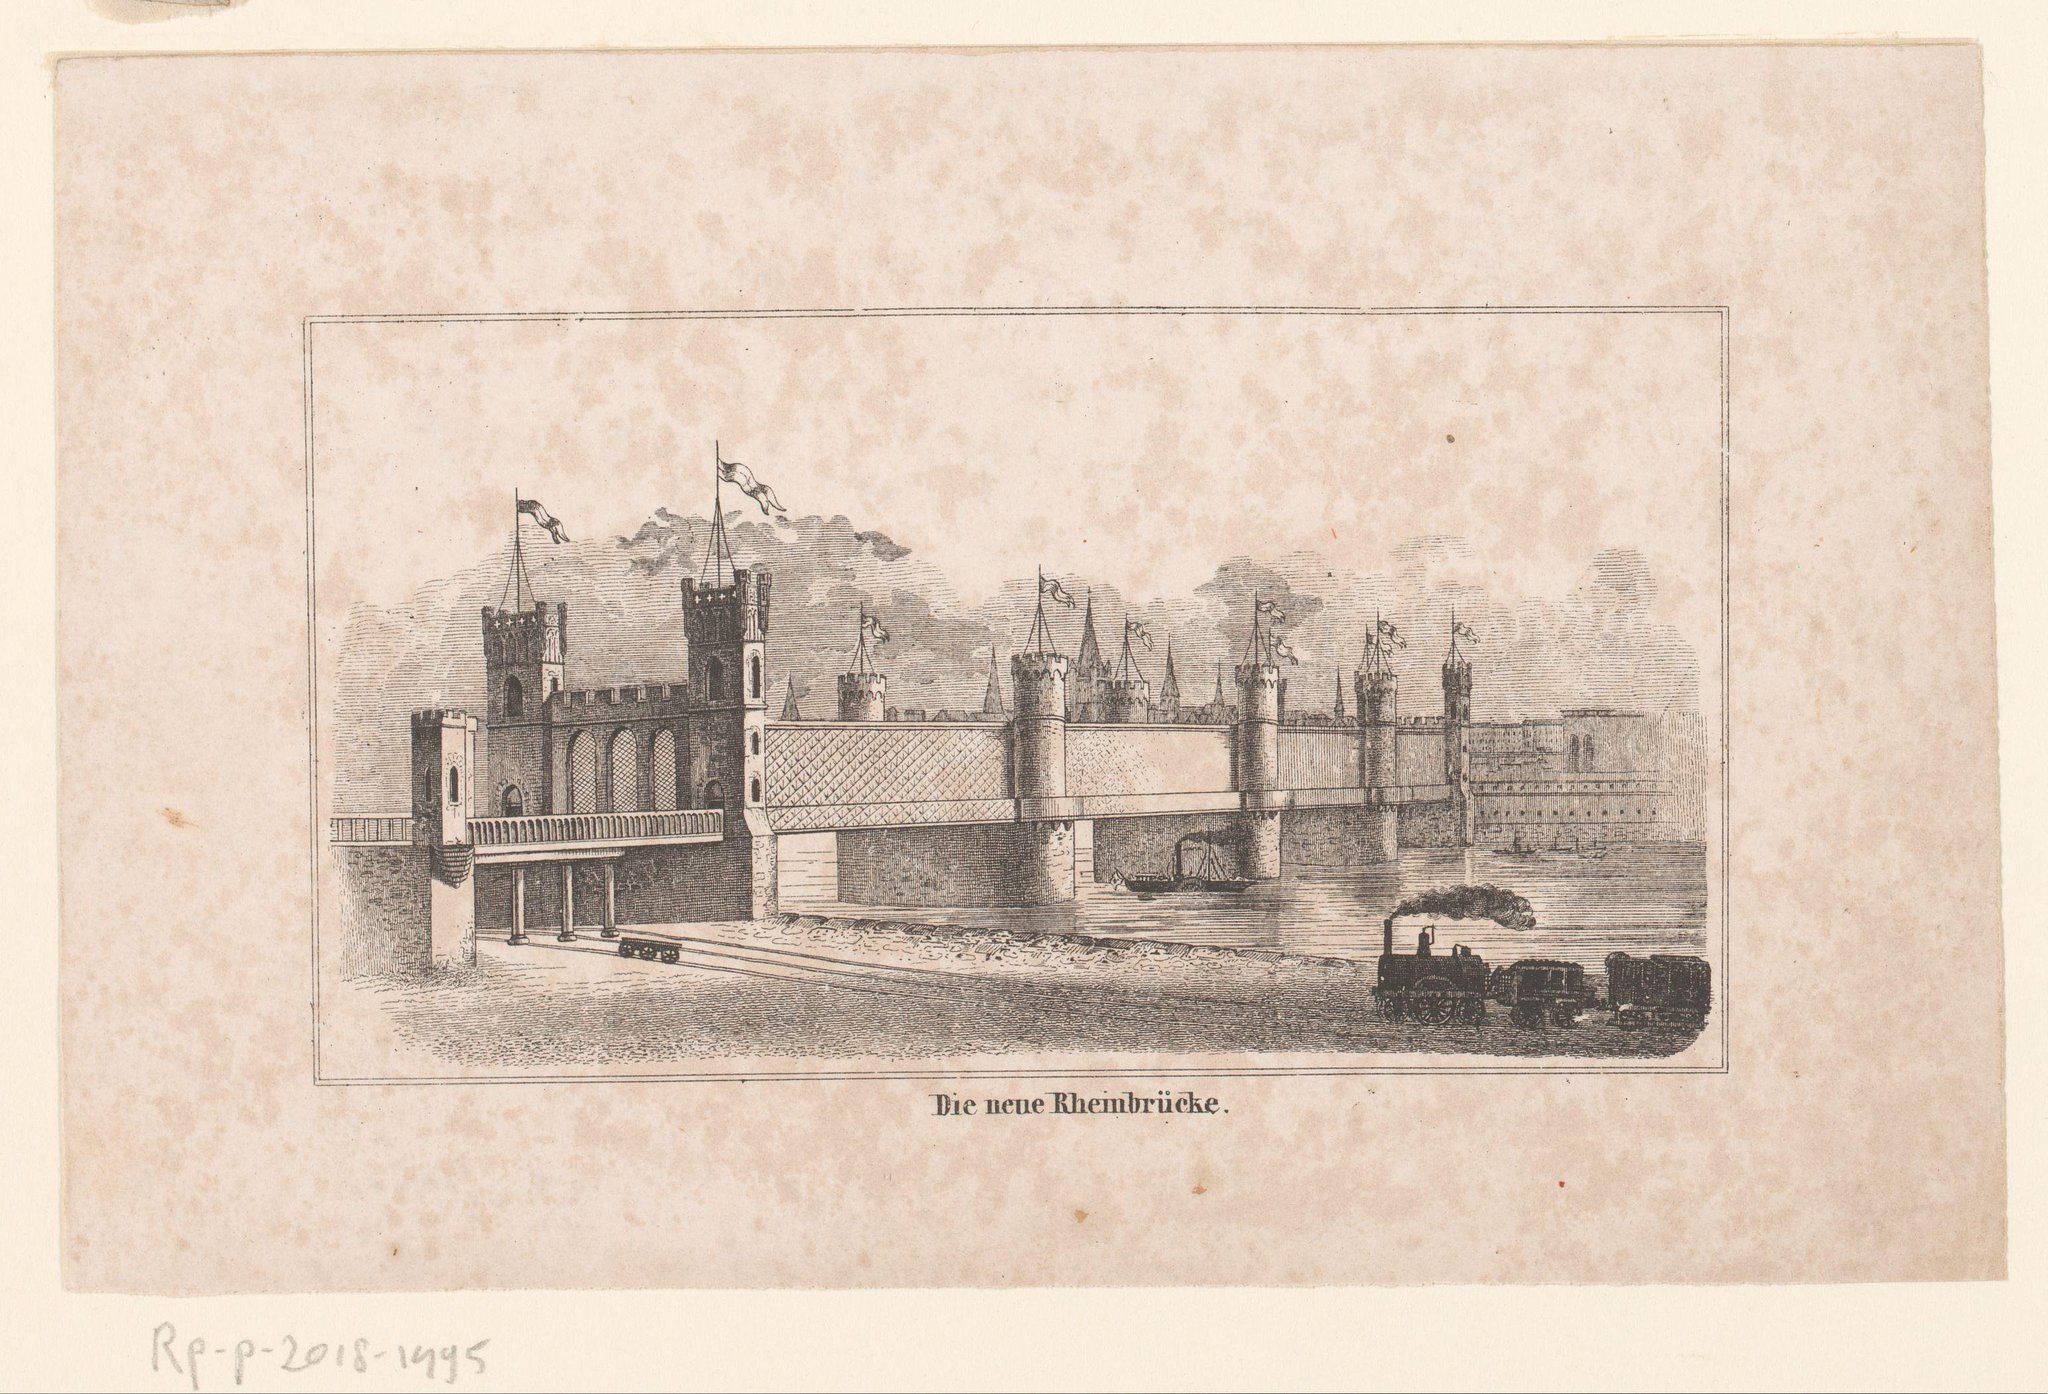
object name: print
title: Gezicht op een brug over de Rijn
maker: Anonymous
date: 1800-1899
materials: paper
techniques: lithograph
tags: bridge, cologne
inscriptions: collector's mark: Lugt 2228